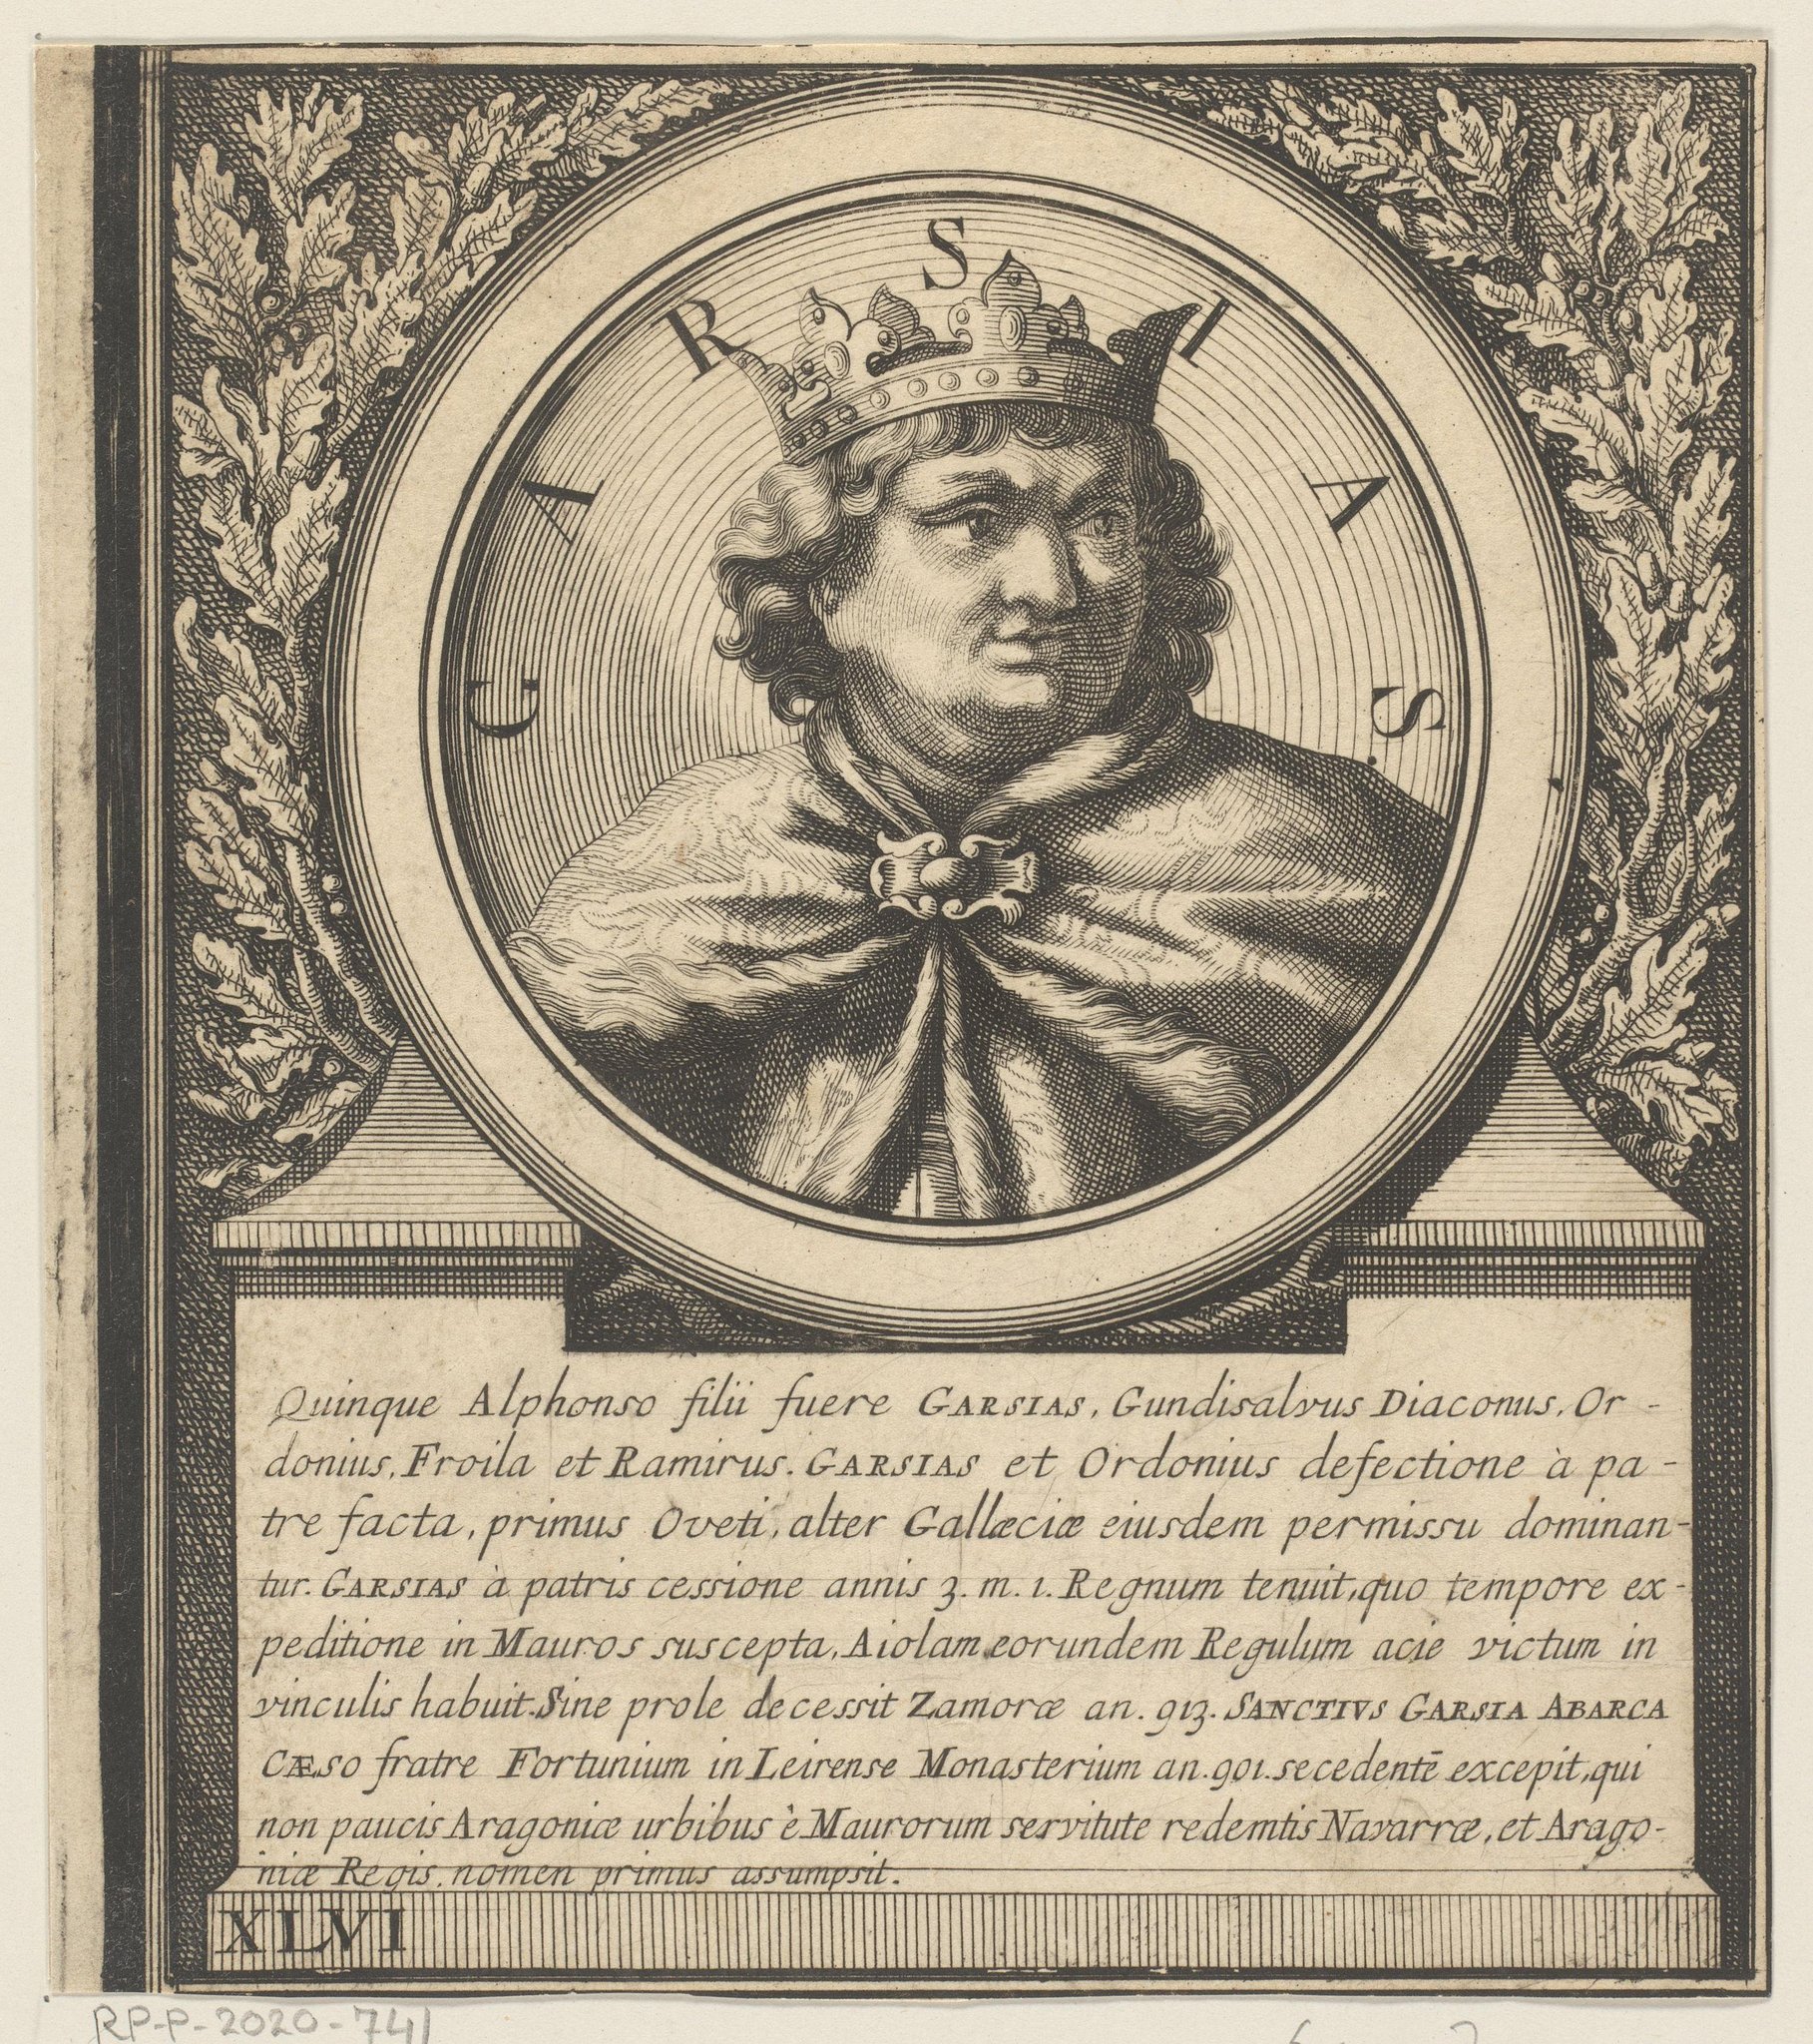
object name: print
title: Portret van García I, koning van León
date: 1698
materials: paper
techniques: engraving, etching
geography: paris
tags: historical persons, ruler, sovereign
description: Portret afkomstig van een grote prent, getiteld 'Series Chronologica et Imagines Regum Hispaniae ab Ataulpho ad Carolum II', bestaande uit meerdere bladen die samengevoegd konden worden, uitgegeven door Petrus de la Tour in 1698.